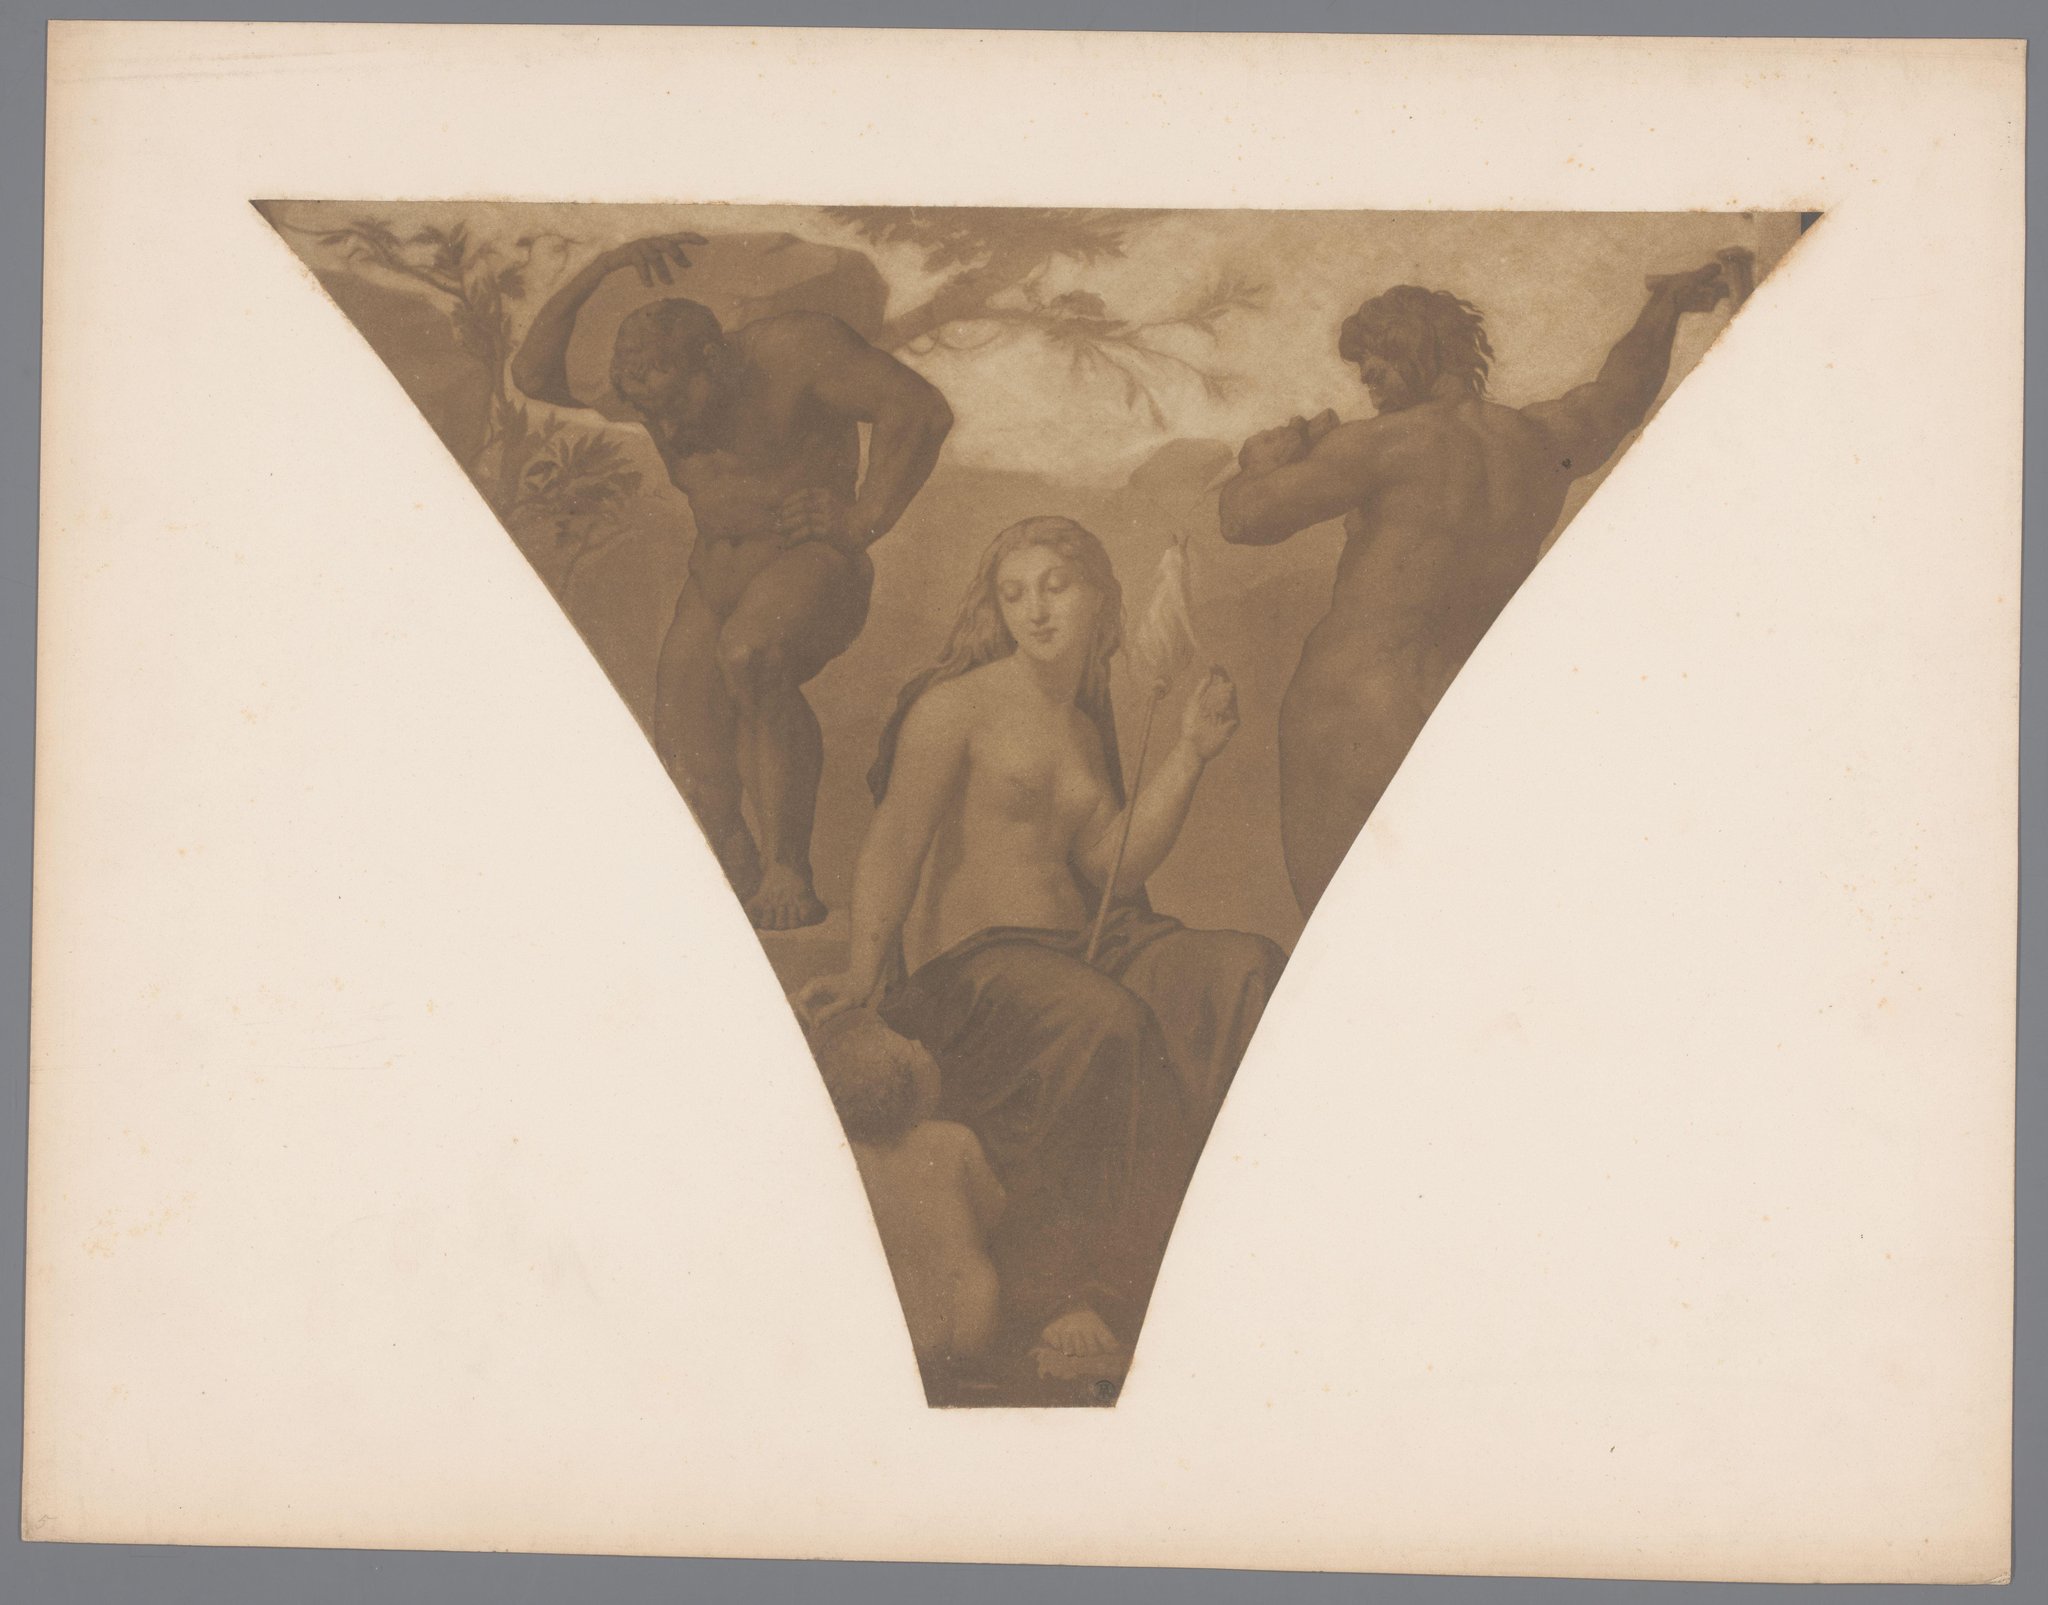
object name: photograph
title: Fotografische reproductie van decoratie aan plafond, Hotel de Ville, Parijs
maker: gustave le gray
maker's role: fotograaf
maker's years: 1820-1884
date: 1852-1853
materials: cardboard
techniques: salted paper print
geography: paris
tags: paris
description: Maakt onderdeel uit van een serie van 18 bladen met foto's van de cartons voor de plafondschilderingen door Henri Lehmann voor de Galerie des Fêtes in het Hotel de Ville, Parijs.